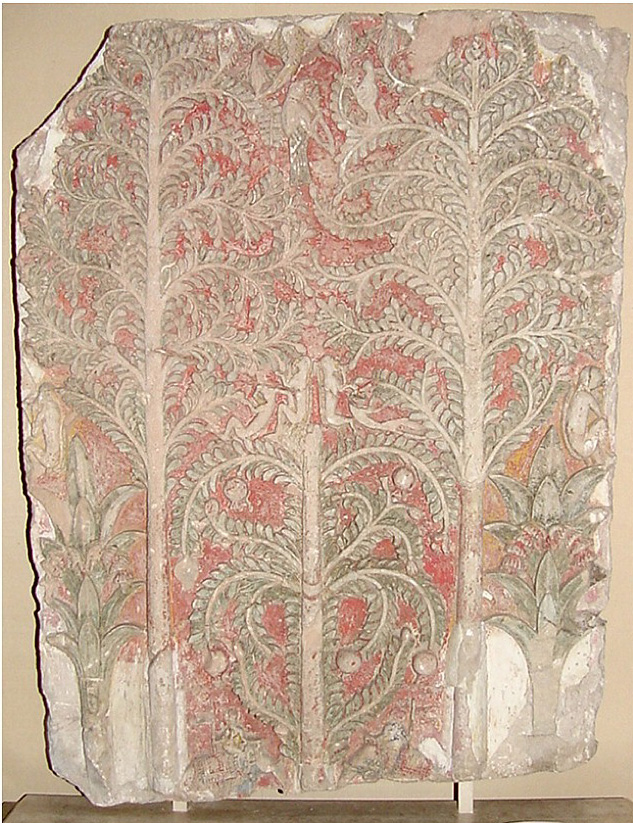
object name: relief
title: Relief with Inhabited Trees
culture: indian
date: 1701-1733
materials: stone, plaster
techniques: polychrome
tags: trees